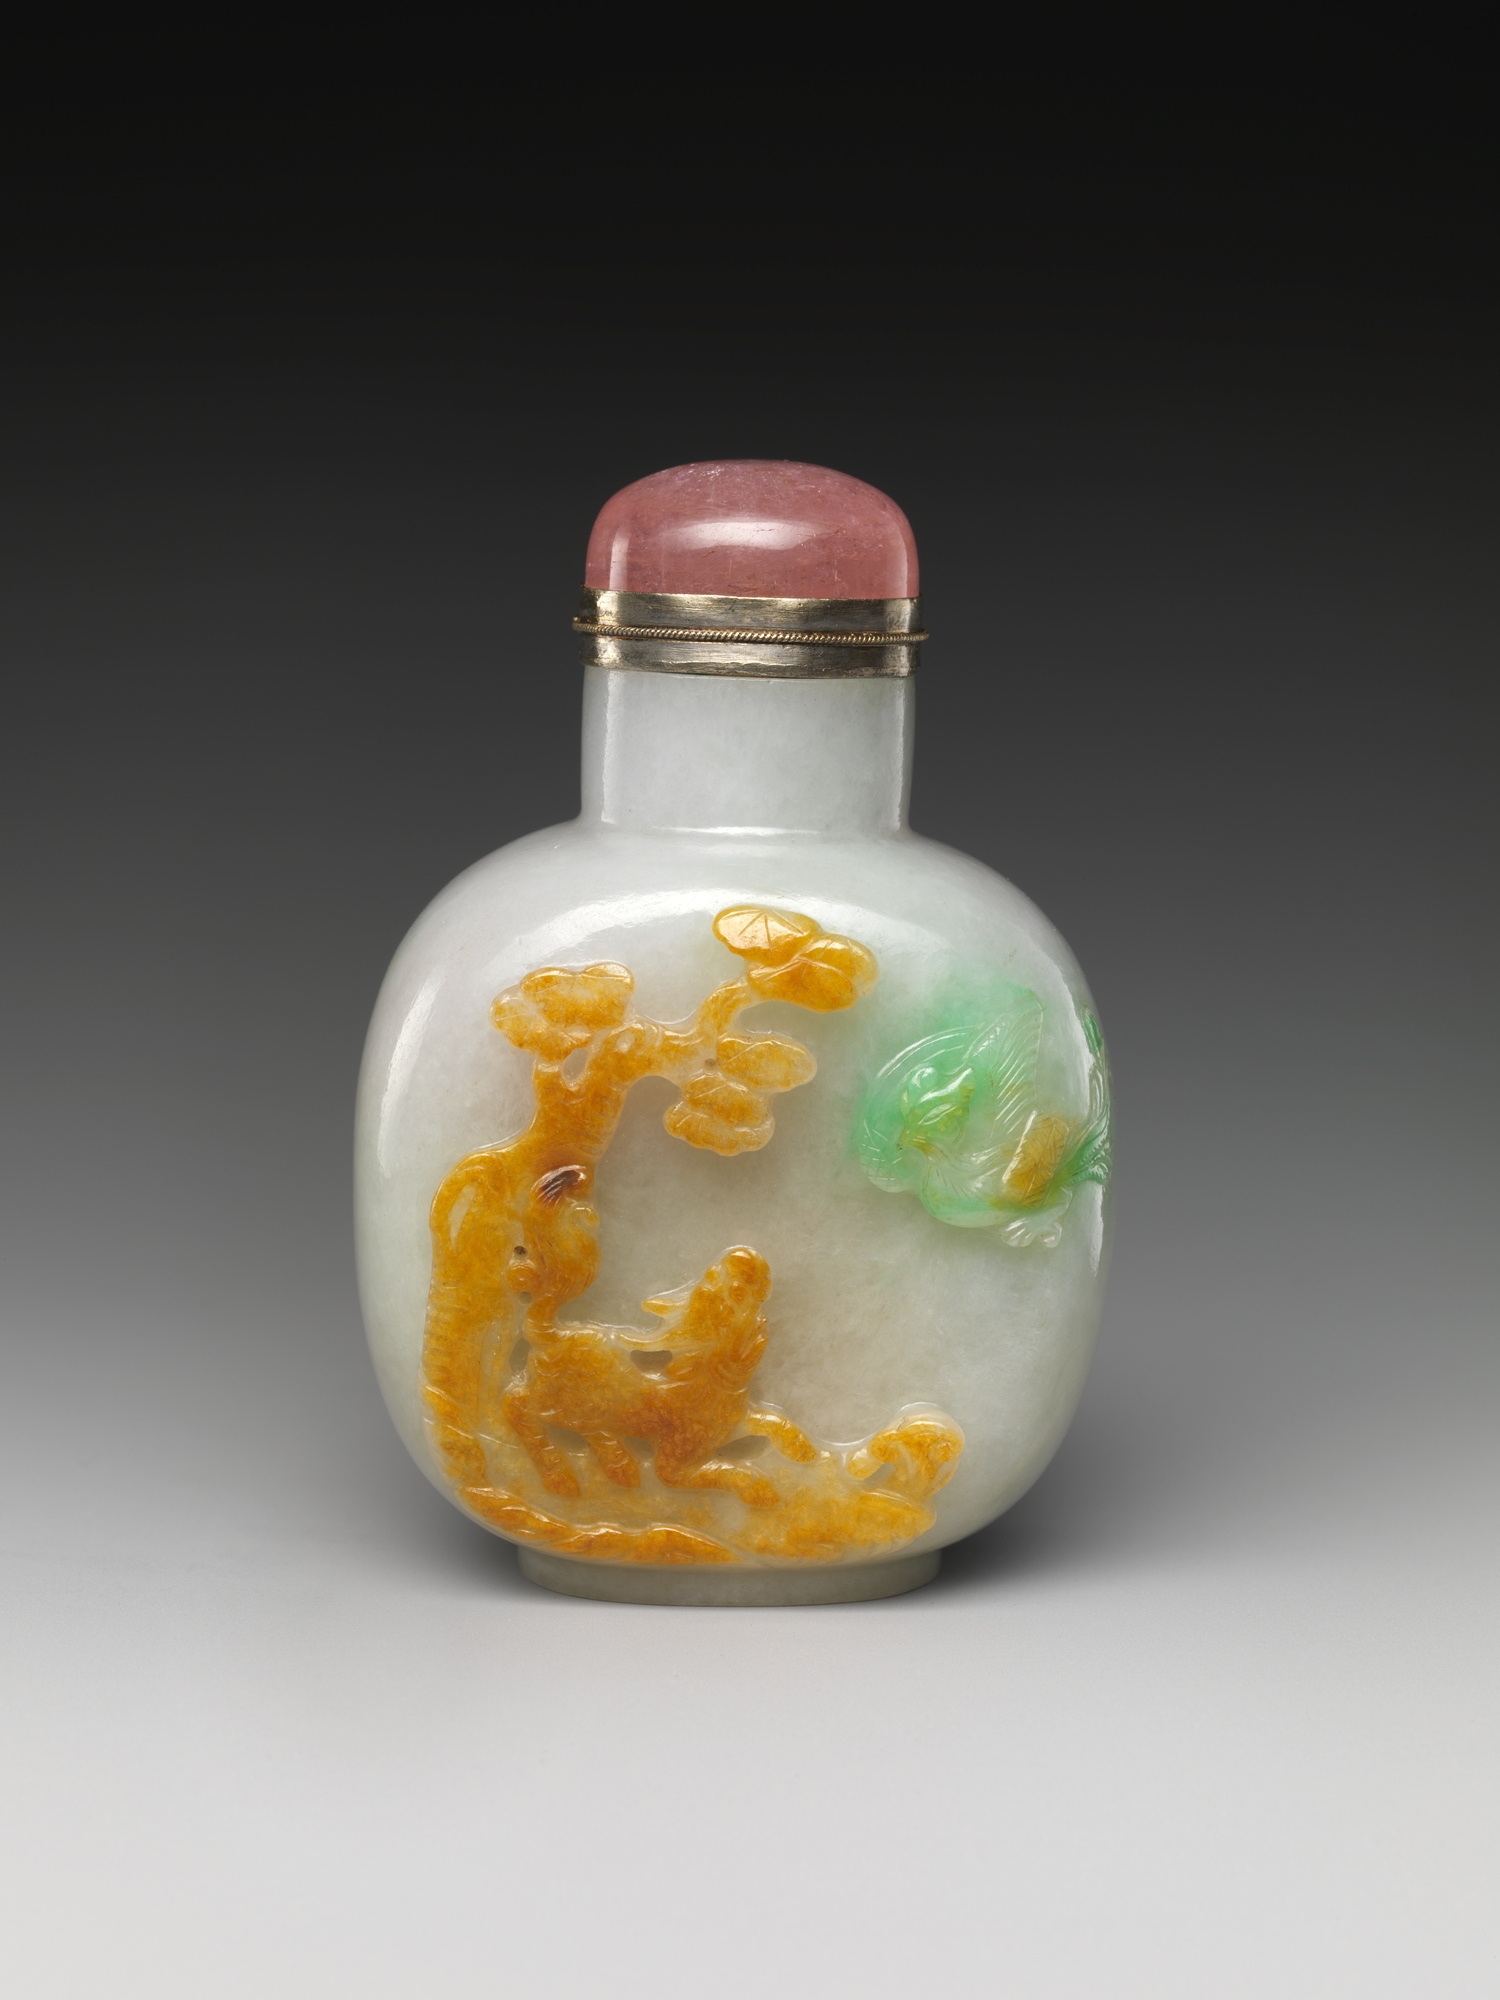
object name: snuff bottle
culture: chinese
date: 1736-1795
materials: gemstone, jade, quartz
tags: animals